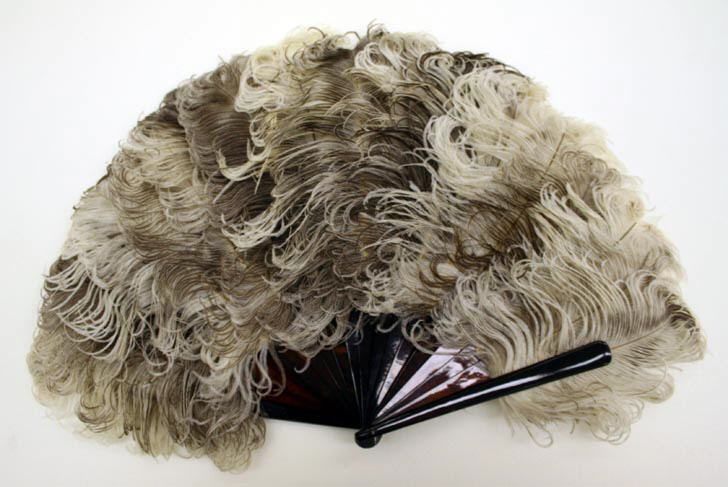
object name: fan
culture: american or european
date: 1867-1900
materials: feather, plastic